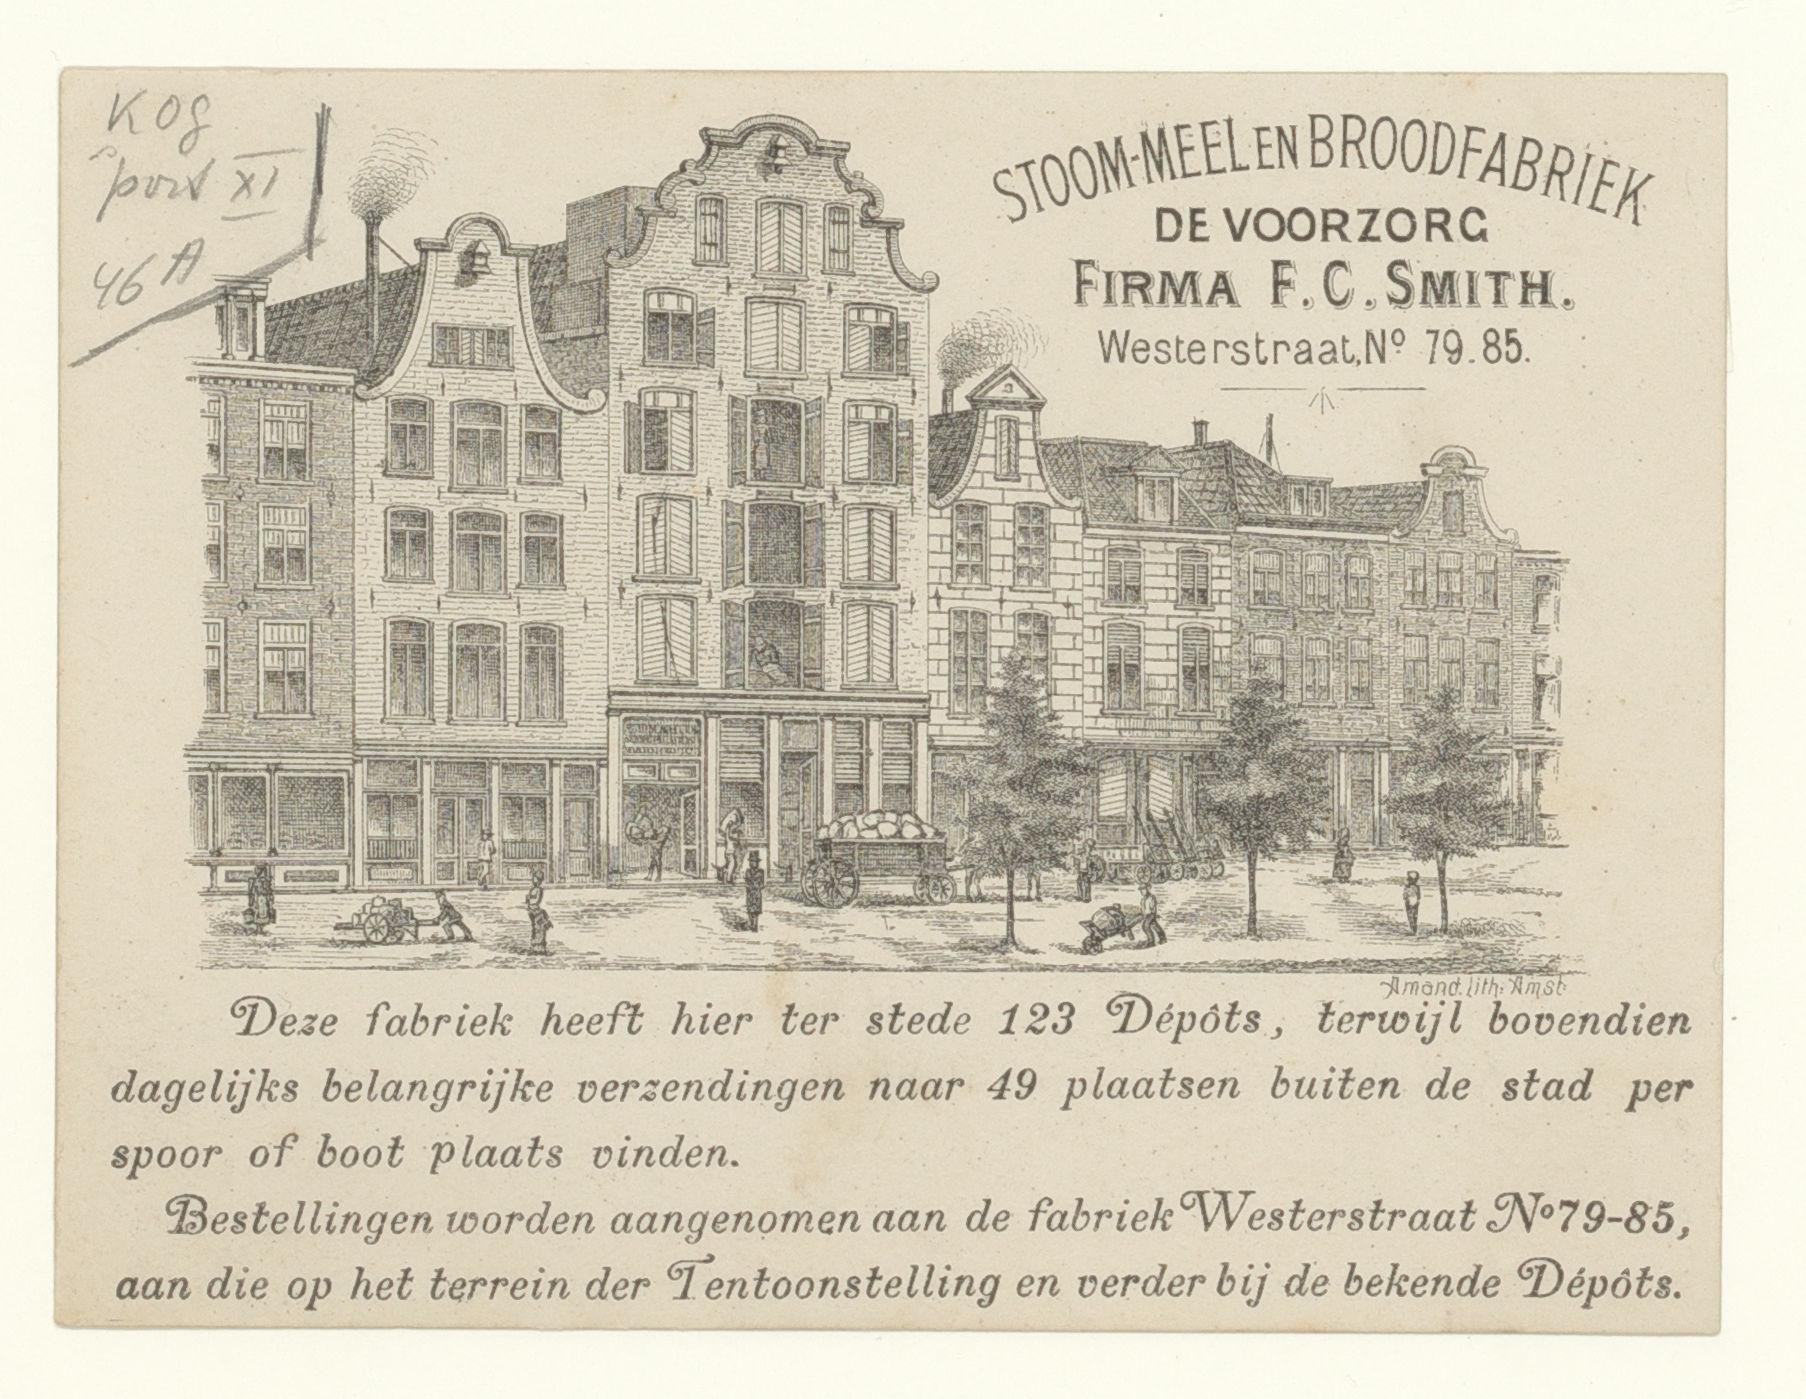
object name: handelsetiket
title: Handelsetiket van Stoom-meel en broodfabriek De Voorzorg Firma F.C. Smith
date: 1867-1894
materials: paper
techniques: lithograph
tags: factory-building, amsterdam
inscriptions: stamp, collector's mark: Lugt 1641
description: Handelsetiket van Stoom-meel en broodfabriek De Voorzorg Firma F.C. Smith. Onderwerpsrubrieken binnen de Atlas Zeden en Gewoonten: Handel, nijverheid en verkeer, Koophandel, Veilingen, Makelaardij en Verzekeringswezen, Oude adreskaarten van winkels en fabrieken, reclame.